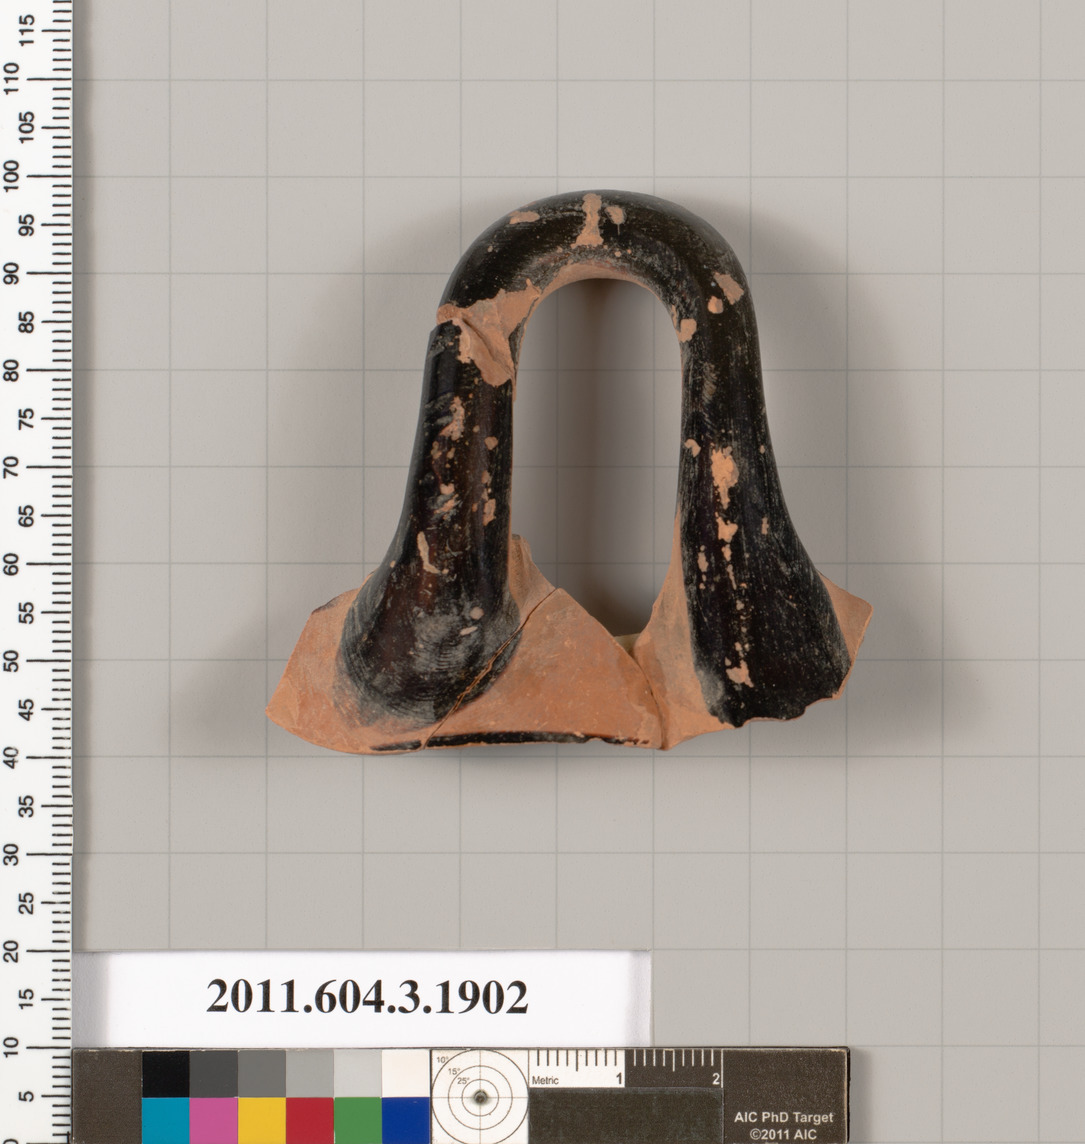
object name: kylix fragment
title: Terracotta fragment of a kylix (drinking cup)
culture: greek, attic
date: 600-401 BCE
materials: terracotta